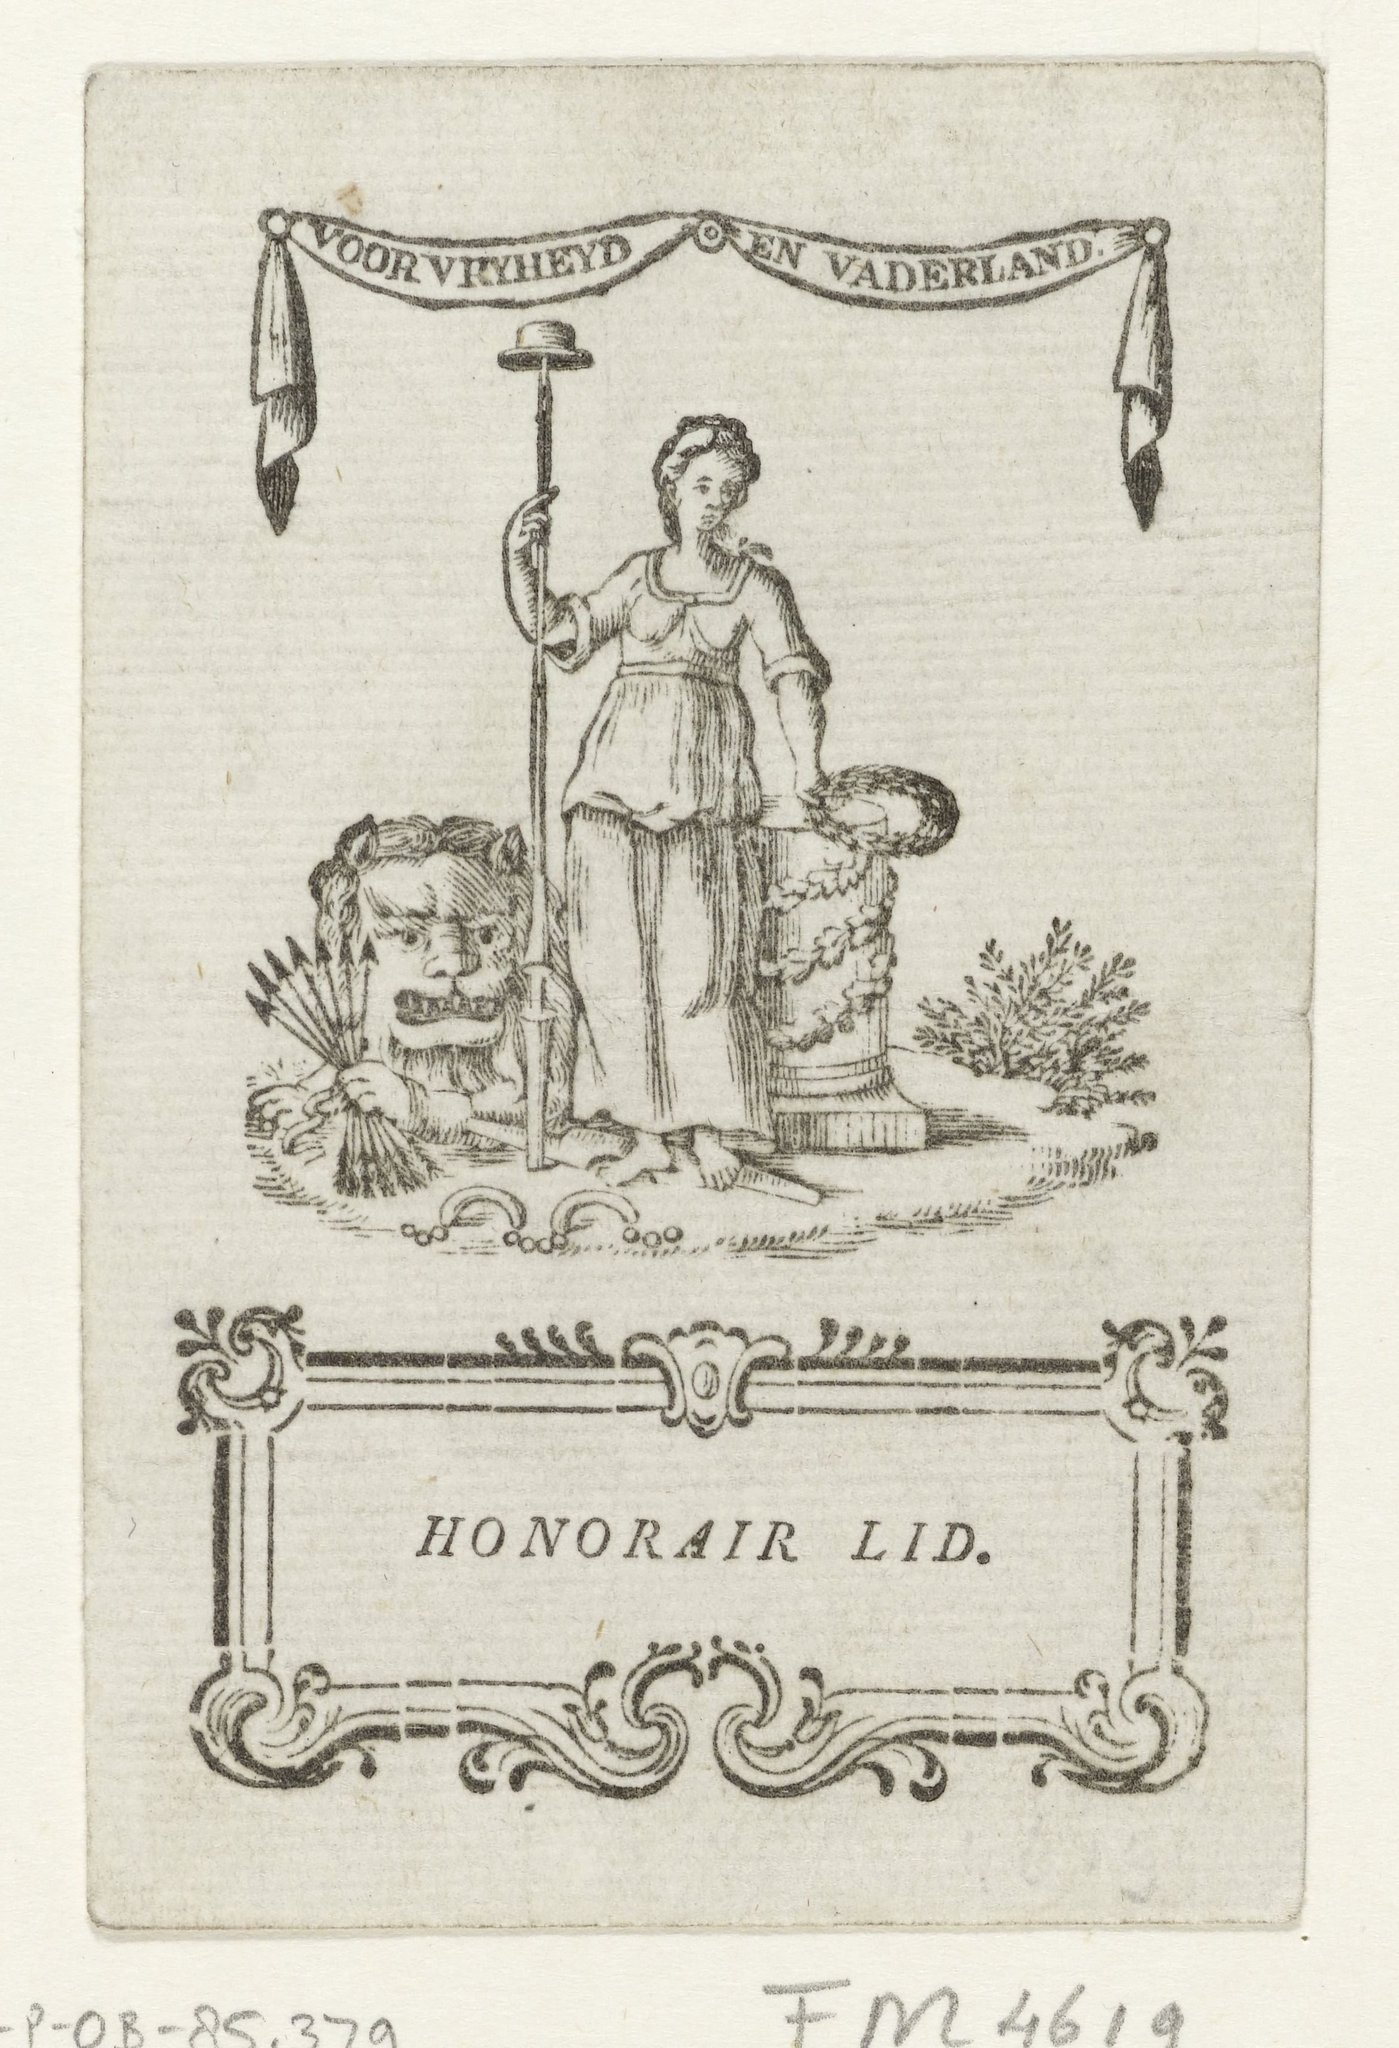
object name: membership certificate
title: Lidmaatschapsbewijs voor het genootschap Voor Vrijheid en Vaderland, ca. 1784-1785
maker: Anonymous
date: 1784-1785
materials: paper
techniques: letterpress printing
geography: northern netherlands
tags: freedom, liberty; 'libertà' (ripa) (+ abstract concept represented by female figure)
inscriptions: collector's mark: Lugt 2228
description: Lidmaatschapsbewijs voor het Leidse Genootschap Voor Vrijheid en Vaderland. Vignet met de Nederlandse Vrijheid met lans en hoed, Nederlandse leeuw en altaar. Daaronder cartouche met: Honorair Lid.